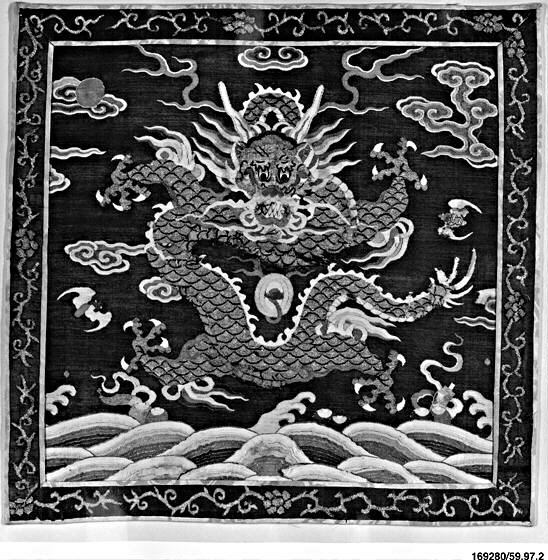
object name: rank badge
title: Rank Badge with Four-Clawed Dragon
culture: chinese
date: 1667-1733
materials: silk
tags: bats,dragons